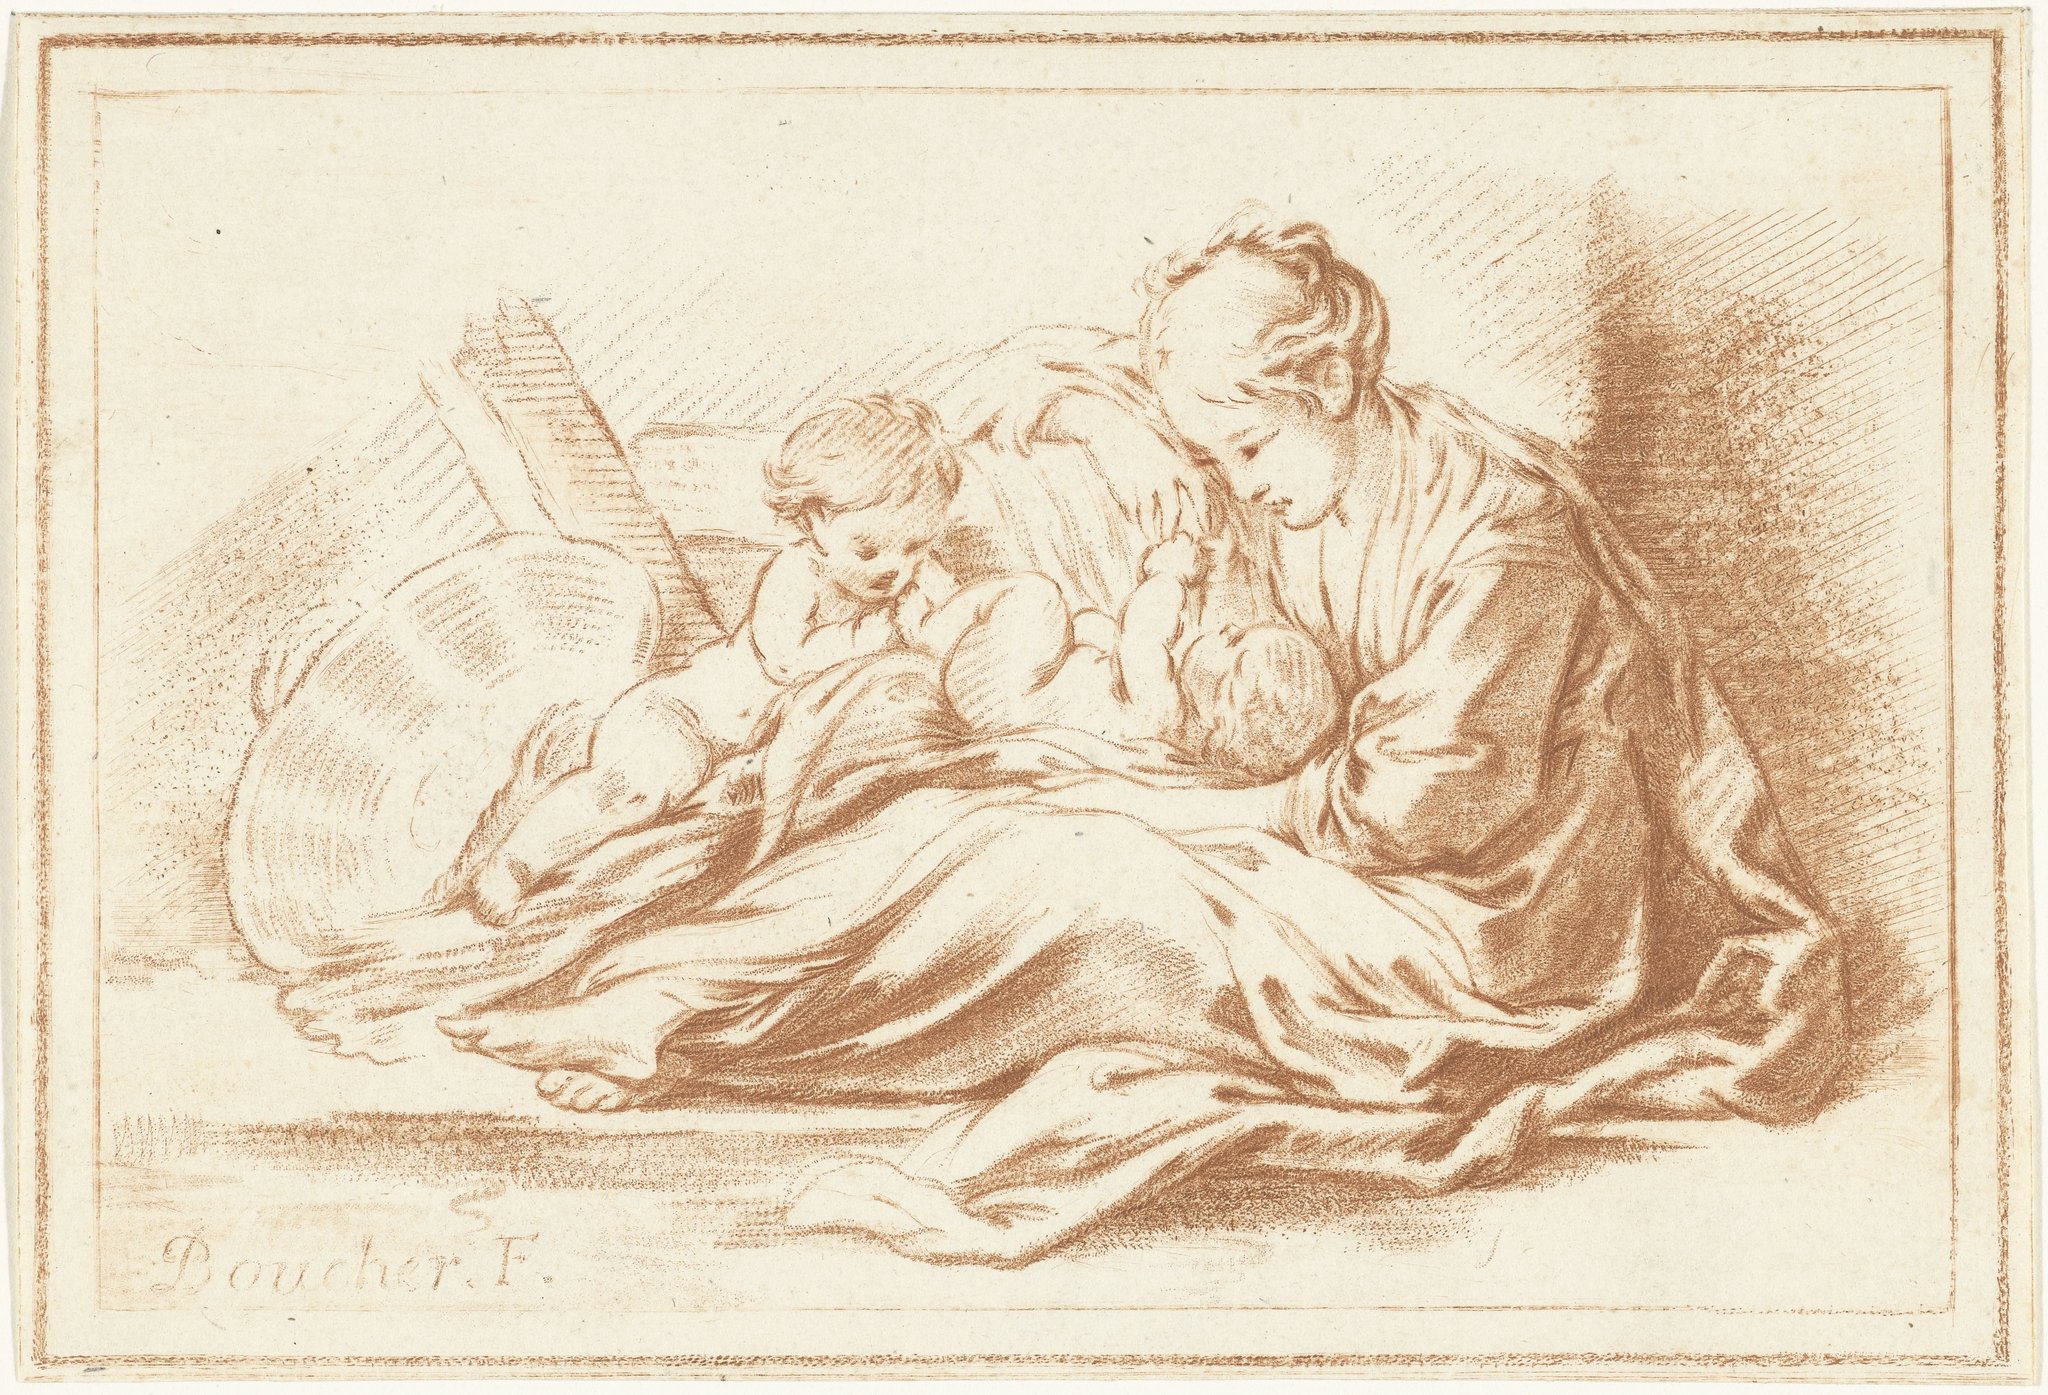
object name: print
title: Moeder en twee kinderen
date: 1724-1798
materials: paper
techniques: printmaking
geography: amsterdam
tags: mother and baby or young child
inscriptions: collector's mark: Lugt 2228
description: Een moeder zit op de grond naast een mand en houdt een baby in haar armen. Naast haar een ander kind.